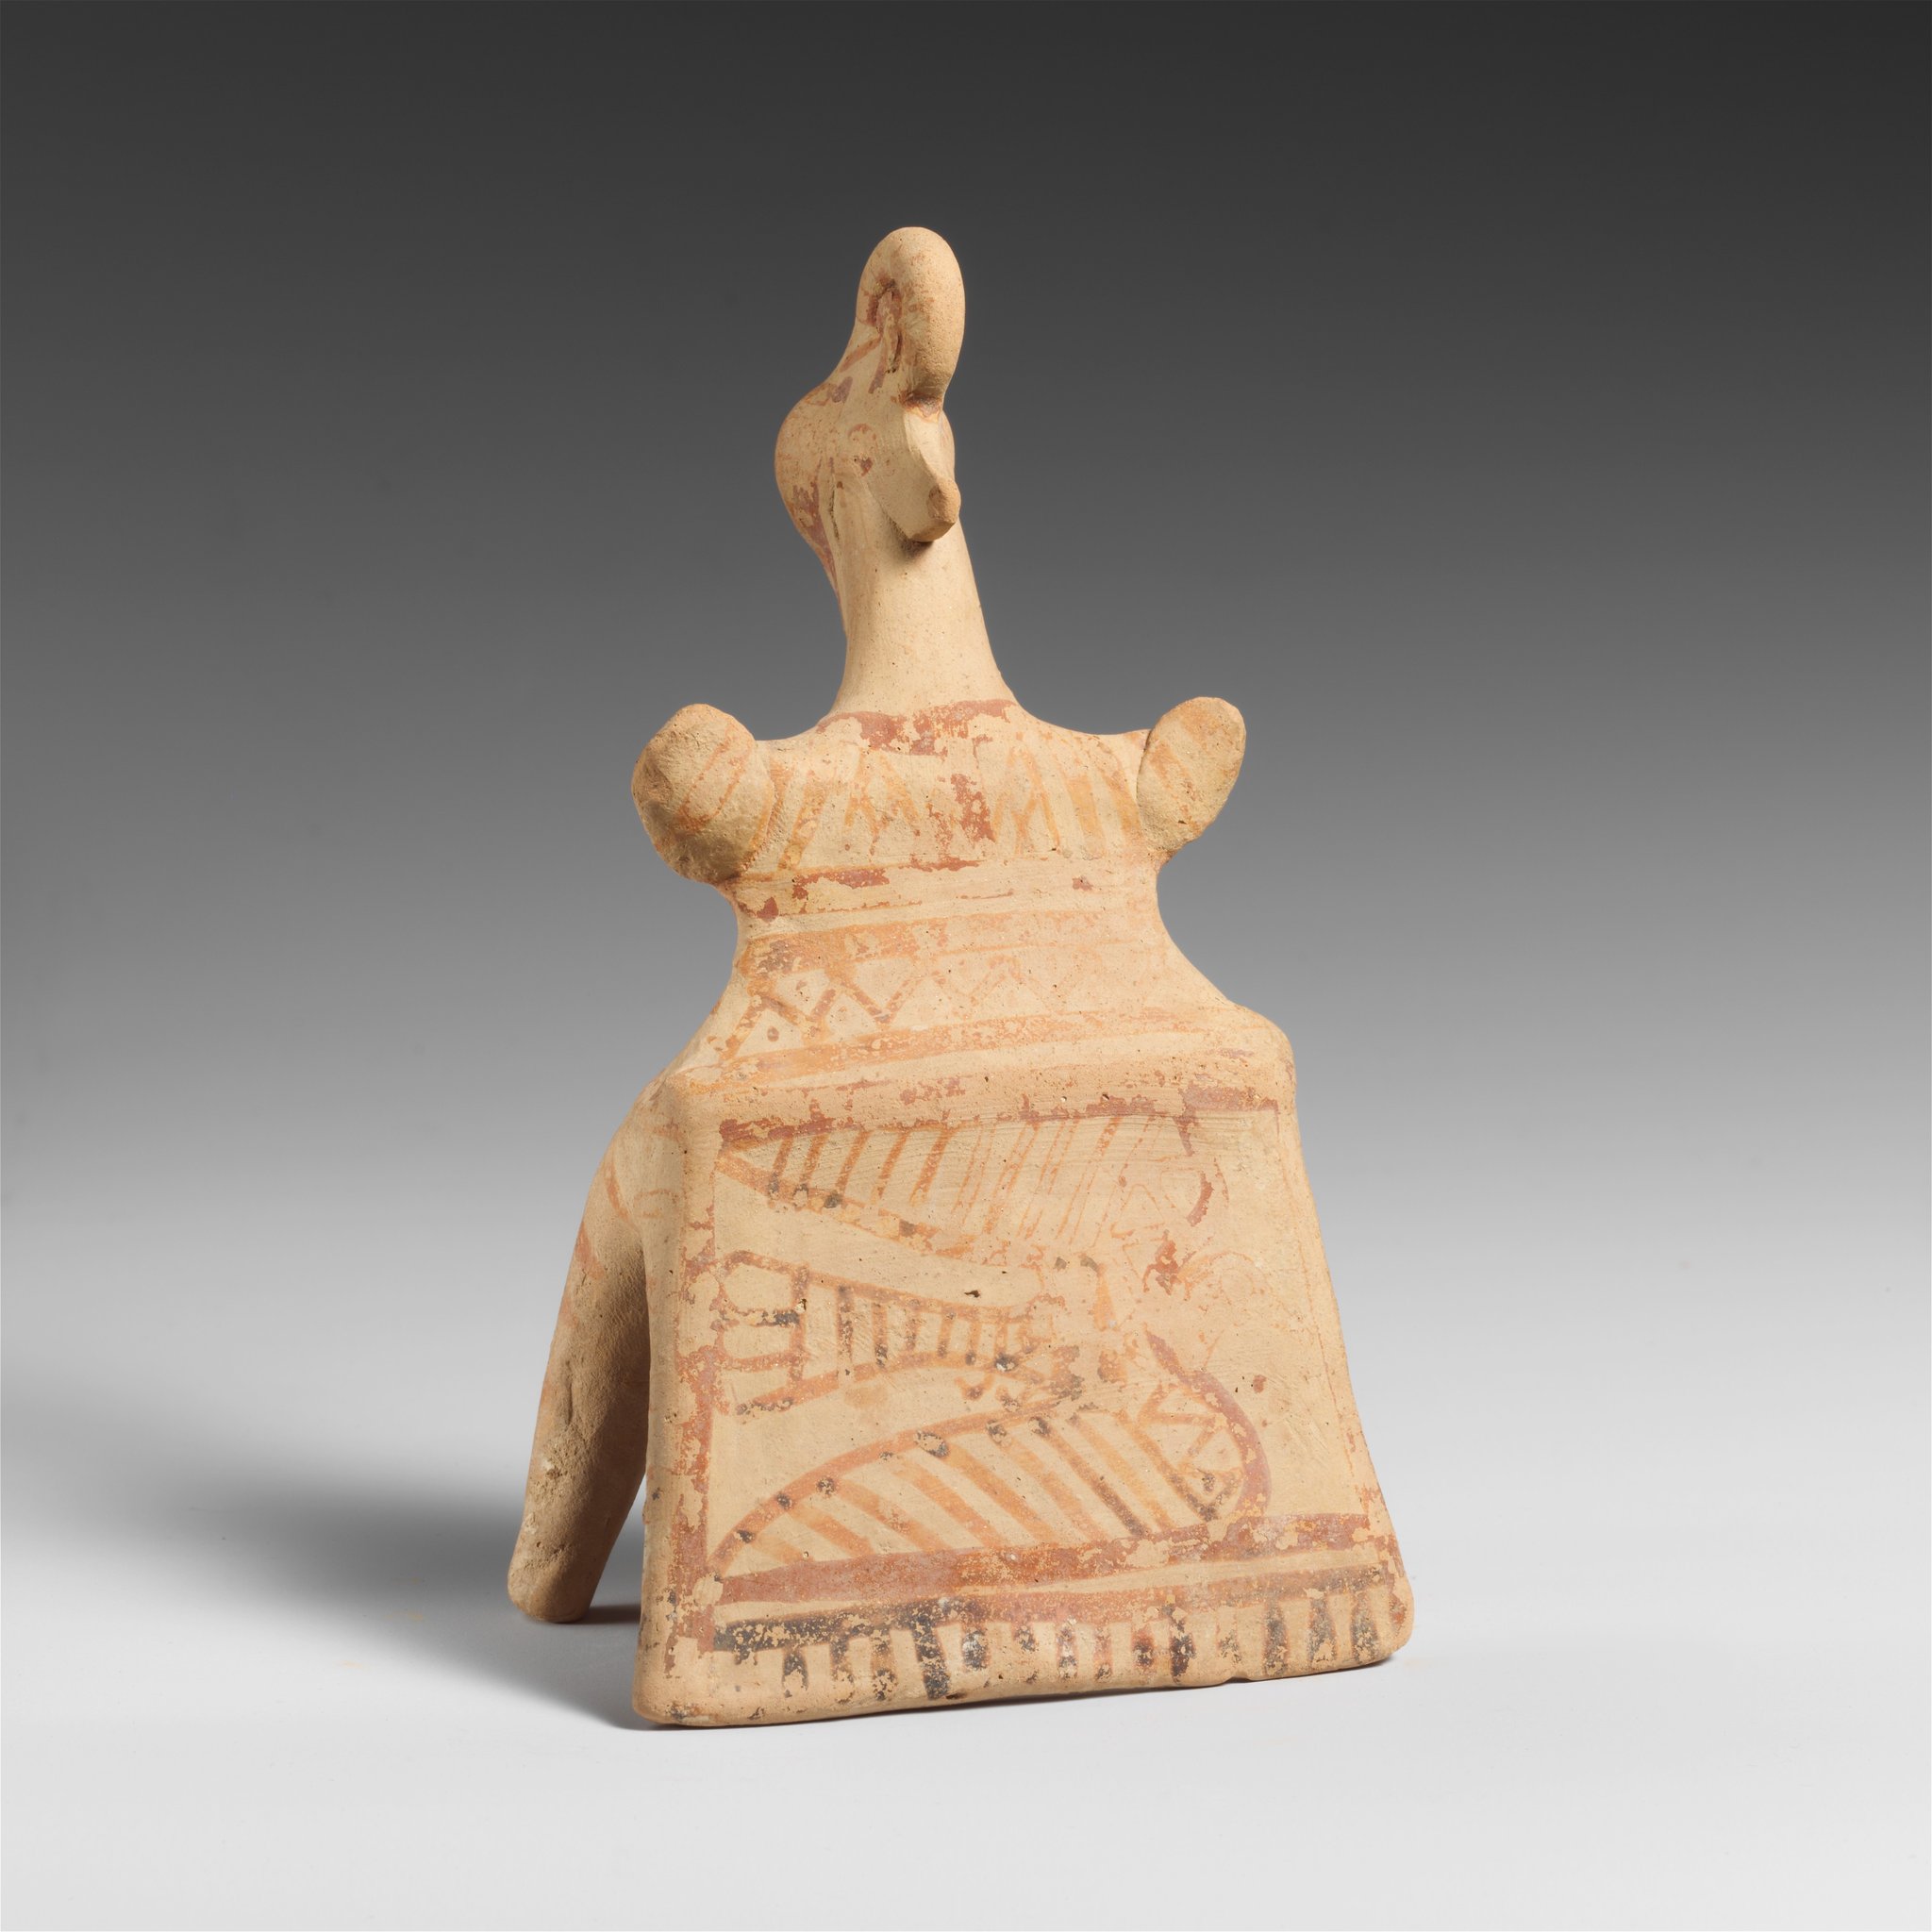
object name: statuette of a woman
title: Terracotta statuette of a seated woman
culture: greek, boeotian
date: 575-550 BCE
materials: terracotta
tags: women